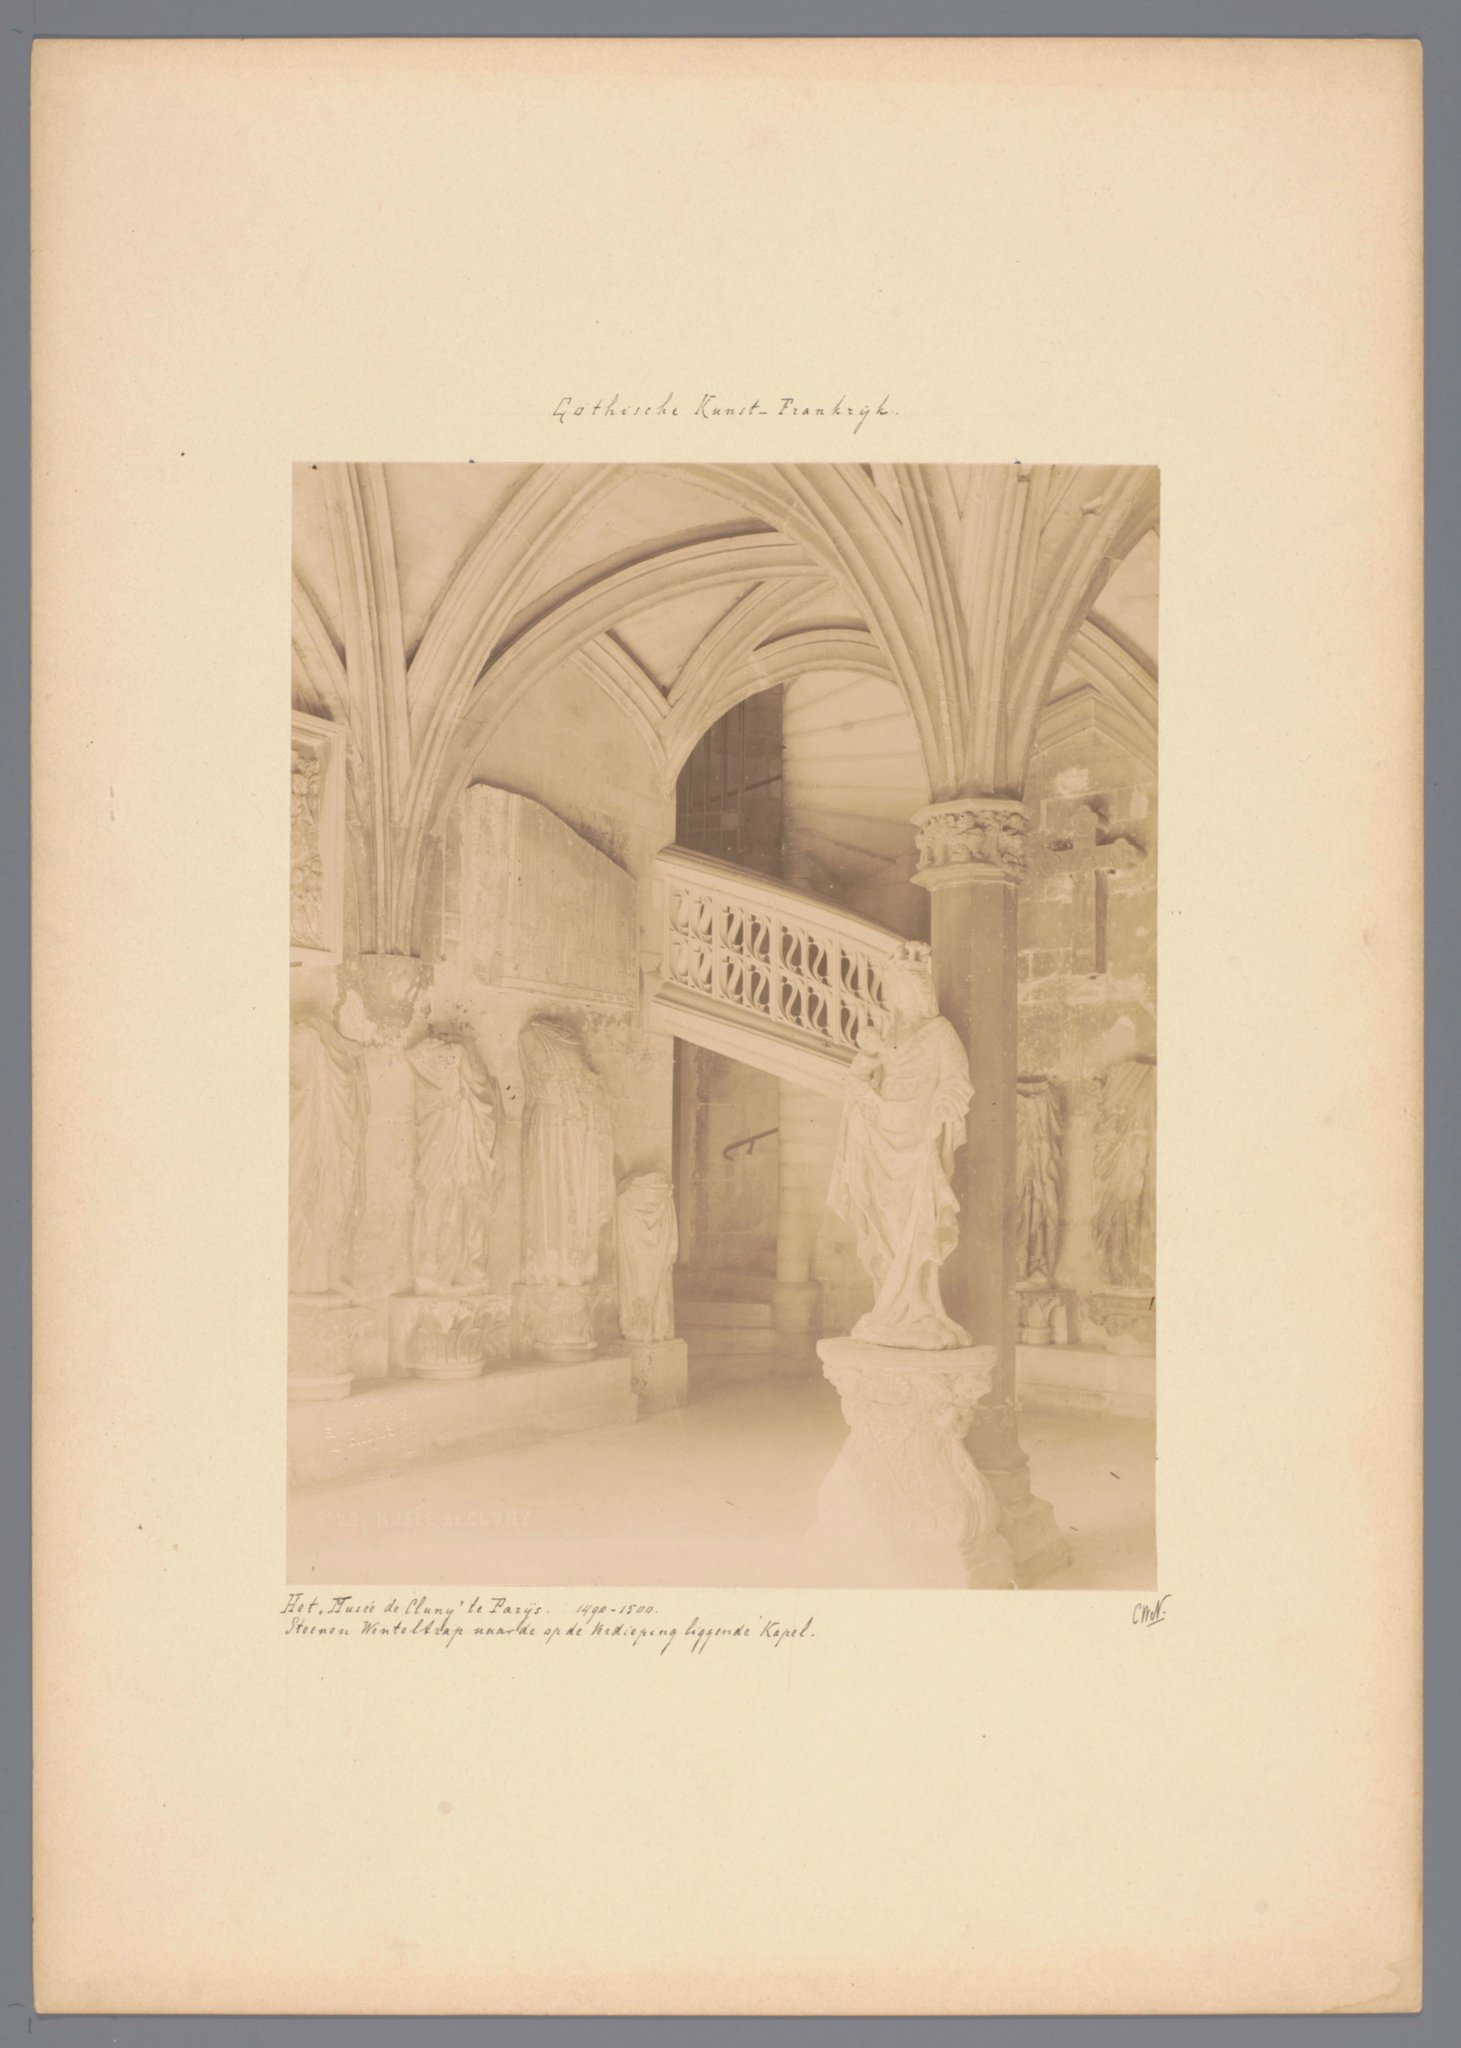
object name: photograph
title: Stenen wenteltrap en sculpturen in de tuin van het Musée de Cluny (Musée national du Moyen Âge) te Parijs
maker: paul robert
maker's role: fotograaf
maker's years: 1865-1905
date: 1875-1900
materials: cardboard, photographic support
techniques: albumen print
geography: paris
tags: piece of sculpture, reproduction of a piece of sculpture, staircase, vault ~ architecture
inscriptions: inscription: ‘Gothische Kunst - Frankrijk.’, collector's mark: ‘KUNSTNIJVERHEIDSCHOOL QUELLINUS AMSTERDAM FRANS HALSSTRAAT 14.’, name: ‘PAUL ROBERT PARIS’, inscription: ‘CWN.’, collector's mark: ‘INSTITUUT VOOR KUNST-NIJVERHEIDSONDERWIJS GABRIËL METSUSTRAAT No. 16 AMSTERDAM’, number: ‘N. 29’